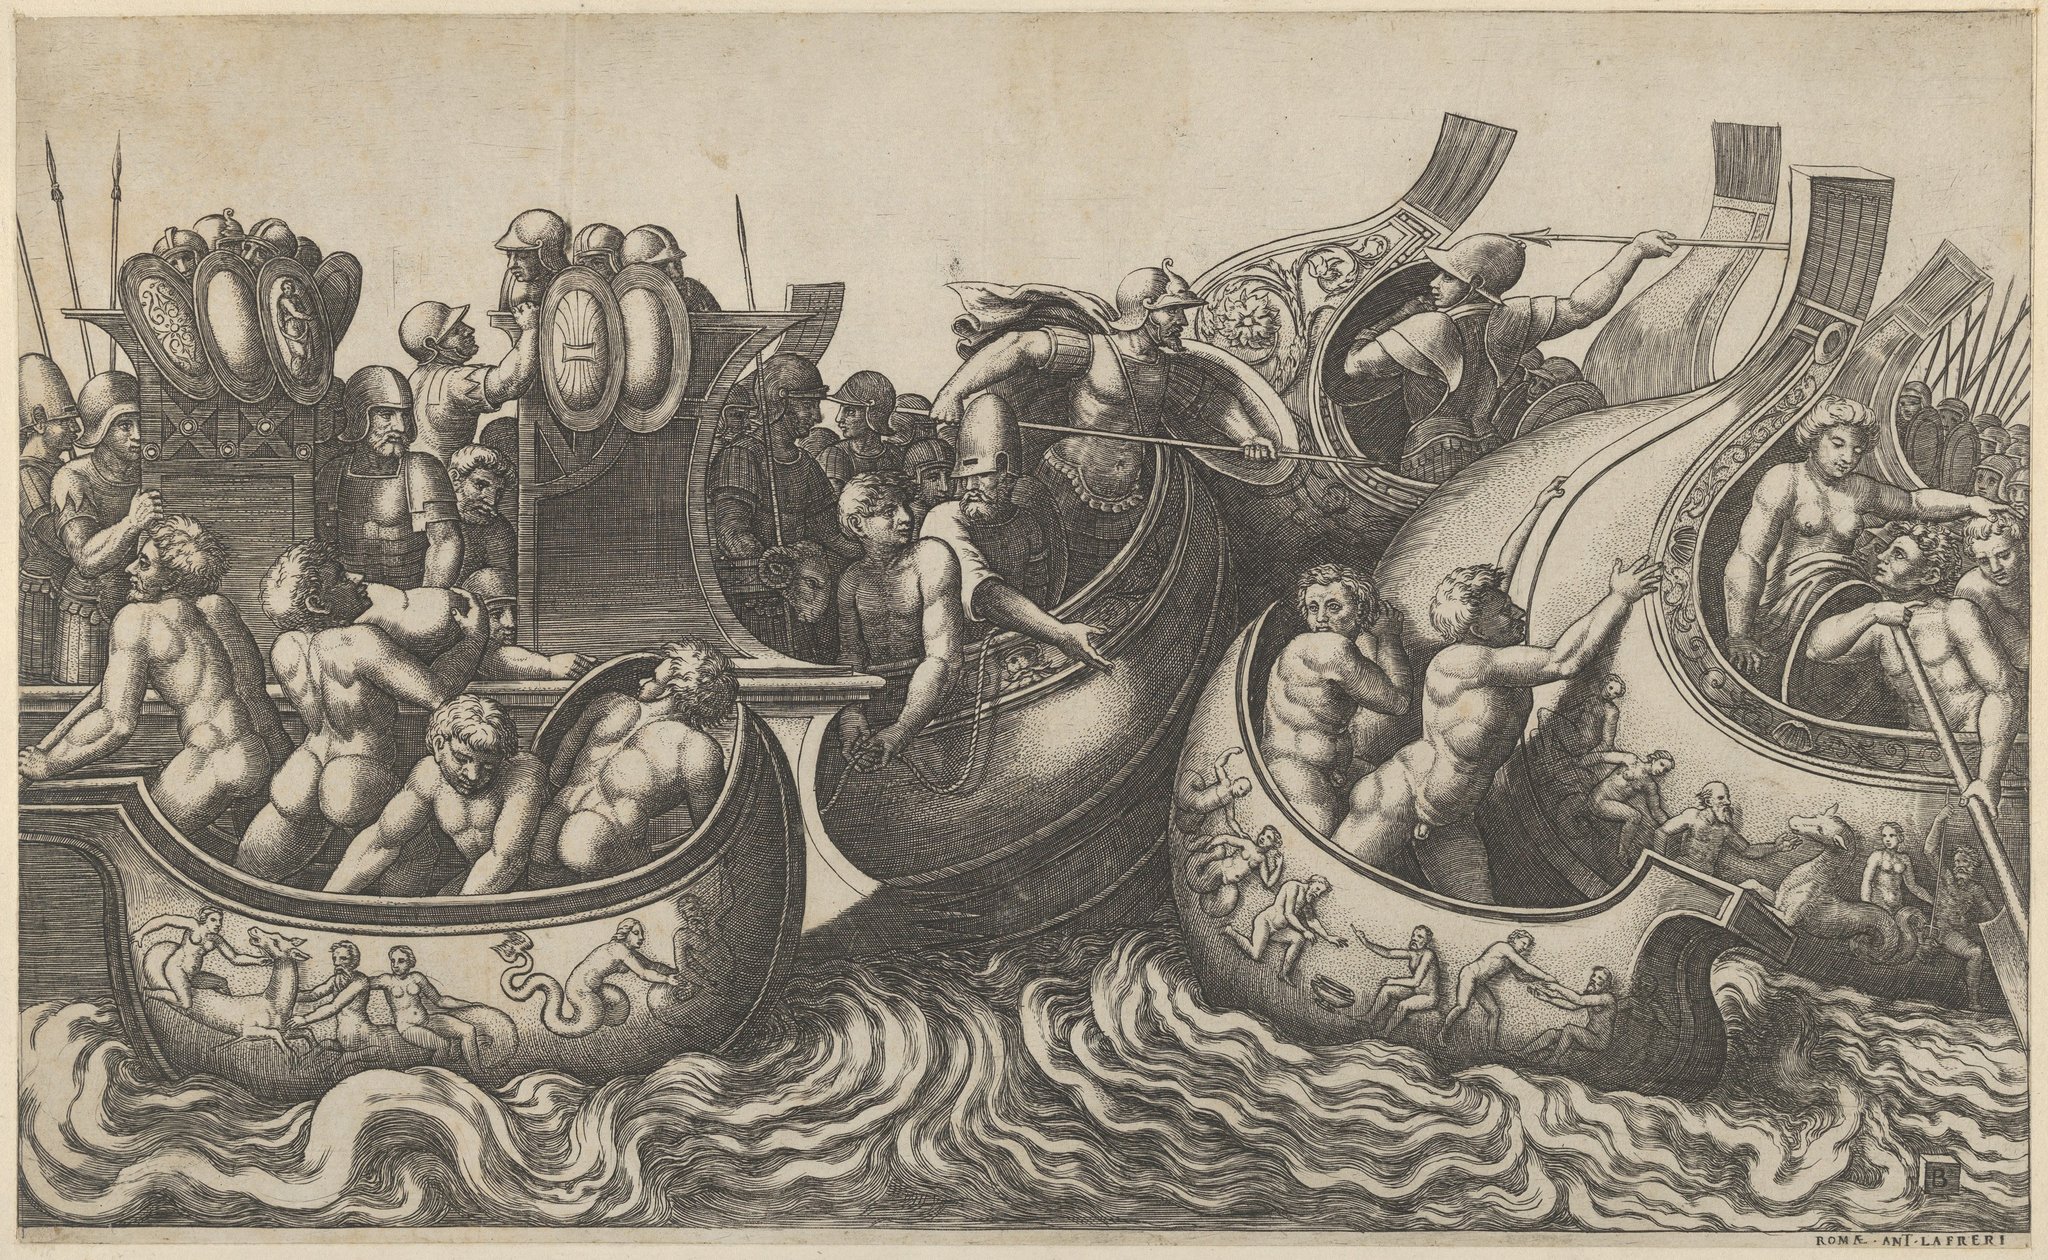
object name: print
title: Naval Battle, from "Speculum Romanae Magnificentiae"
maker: master of the die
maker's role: artist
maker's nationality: italian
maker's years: 1525-1560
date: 1501-1600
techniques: engraving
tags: battles,soldiers,spears,male nudes,boats